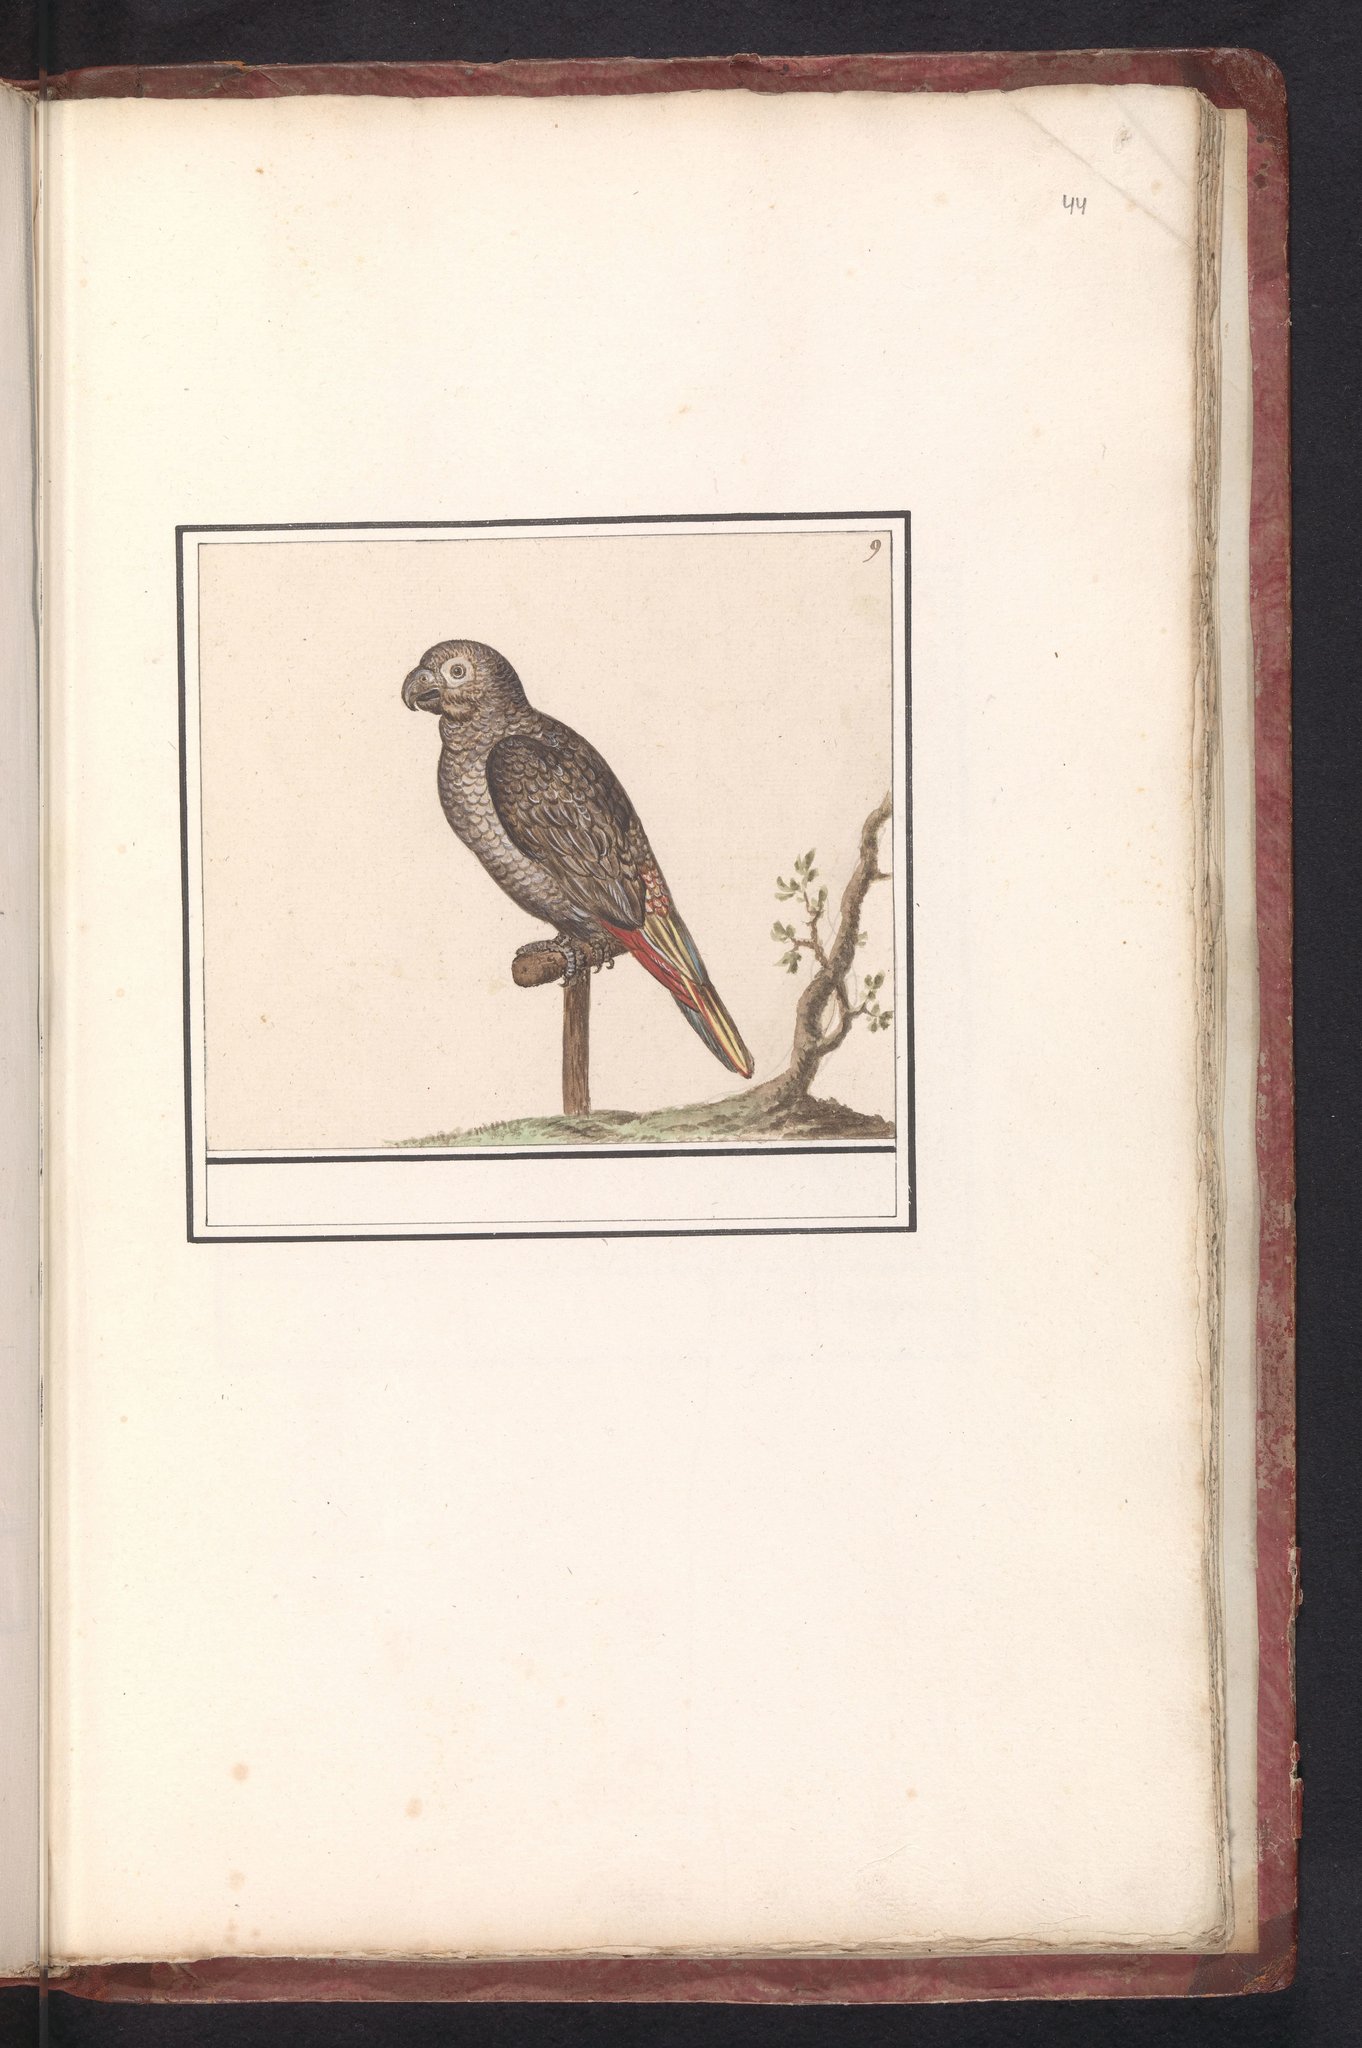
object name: drawing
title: Papegaai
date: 1596-1610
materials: paint, paper, pencil, watercolor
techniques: brush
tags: ornamental birds: parrot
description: Papegaai op een stok. Genummerd rechtsboven: 9. Onderdeel van het tweede album met tekeningen van vogels. Vierde van twaalf albums met tekeningen van dieren, vogels en planten bekend rond 1600, gemaakt in opdracht van keizer Rudolf II. Met toelichting in Nederlands, Latijn en Frans.